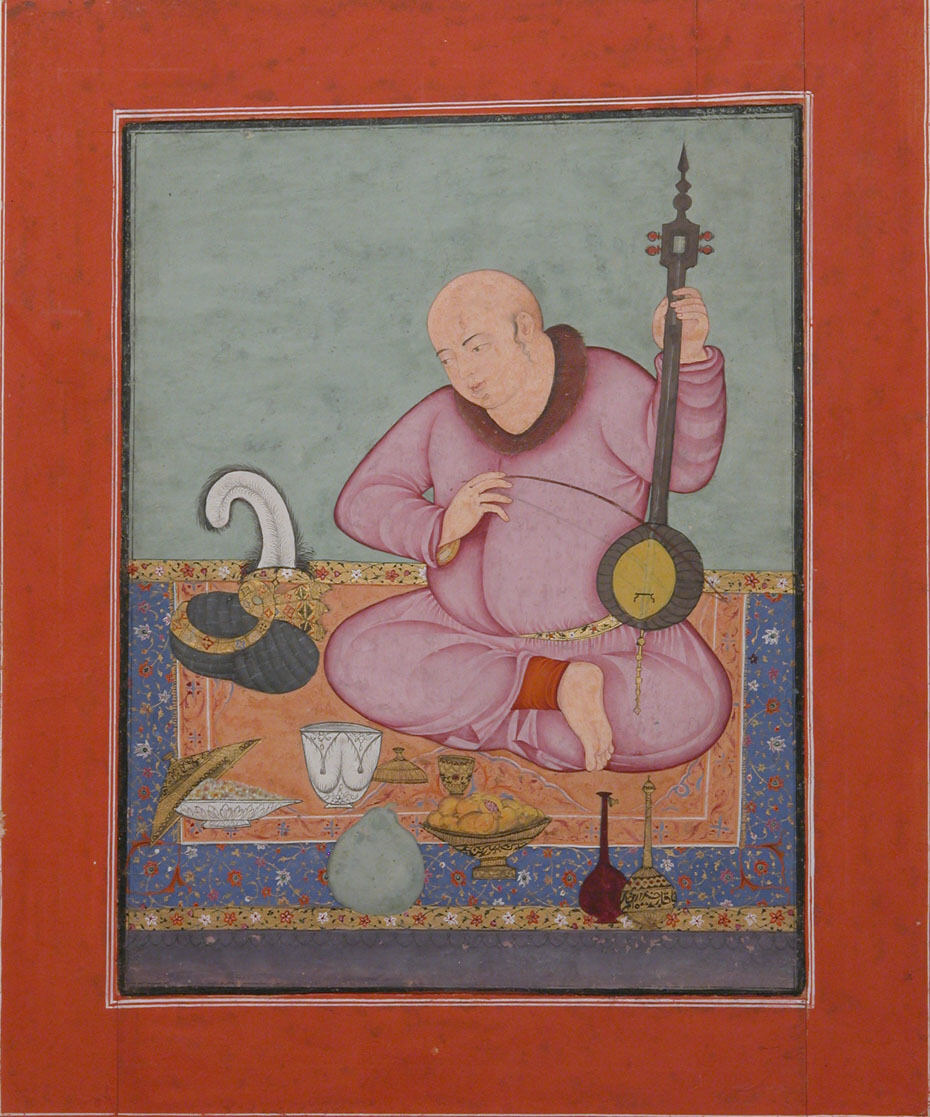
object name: illustrated single work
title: Portrait of a Muslim Saint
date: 1667-1700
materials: gold, paper, watercolor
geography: india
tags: musical instruments,men,portraits